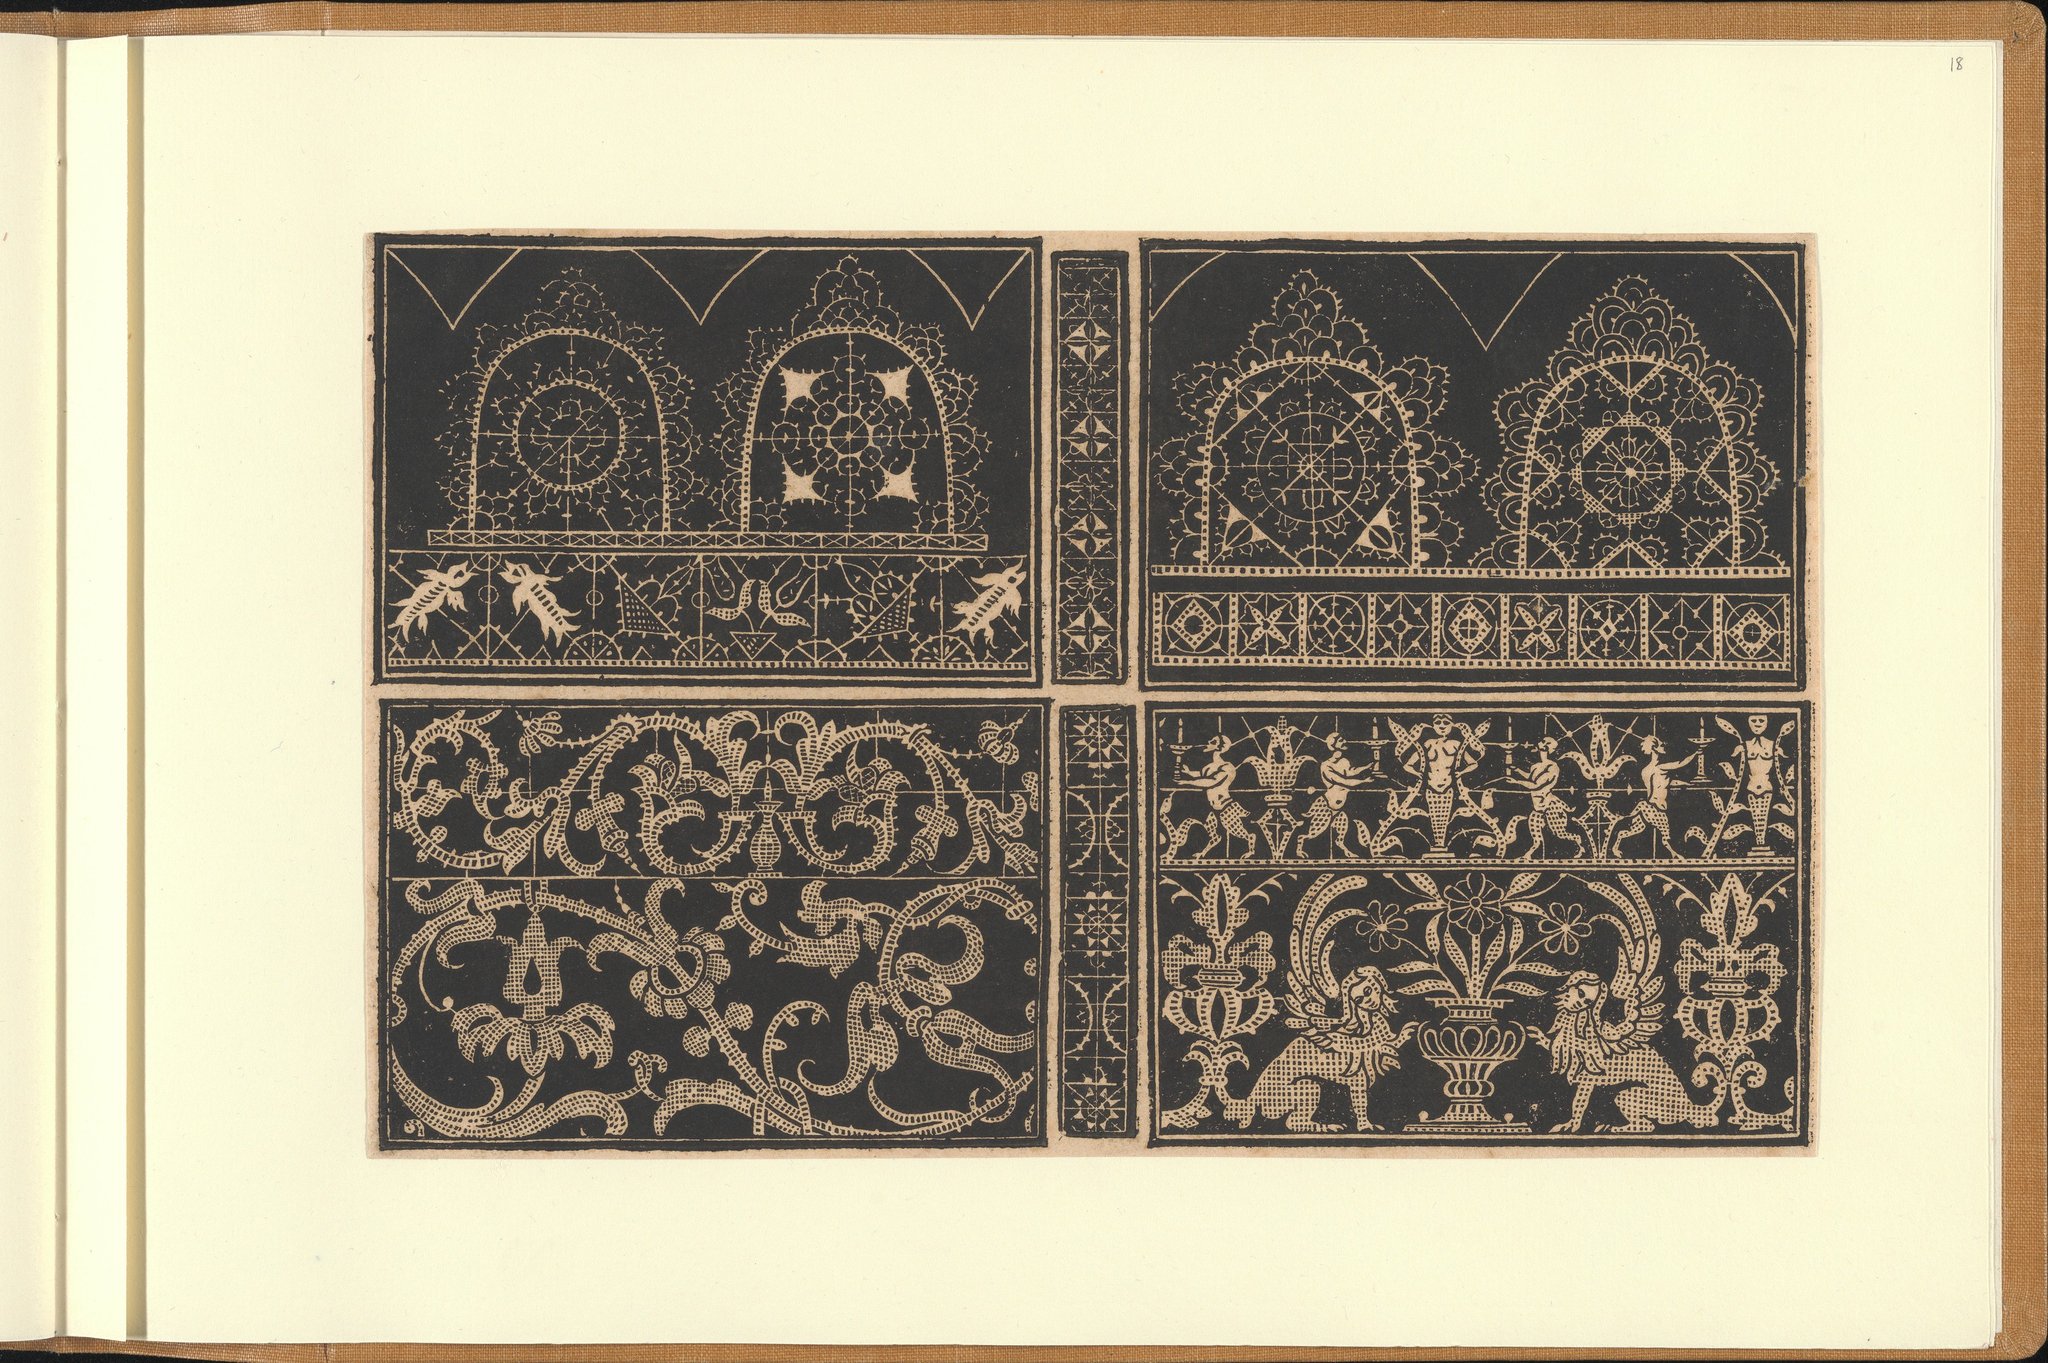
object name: album print ornament architecture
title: Schon newes Modelbuch...Page 18(r)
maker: sigismundus latomus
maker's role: designer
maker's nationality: german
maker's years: 1599-1632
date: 1617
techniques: woodcut